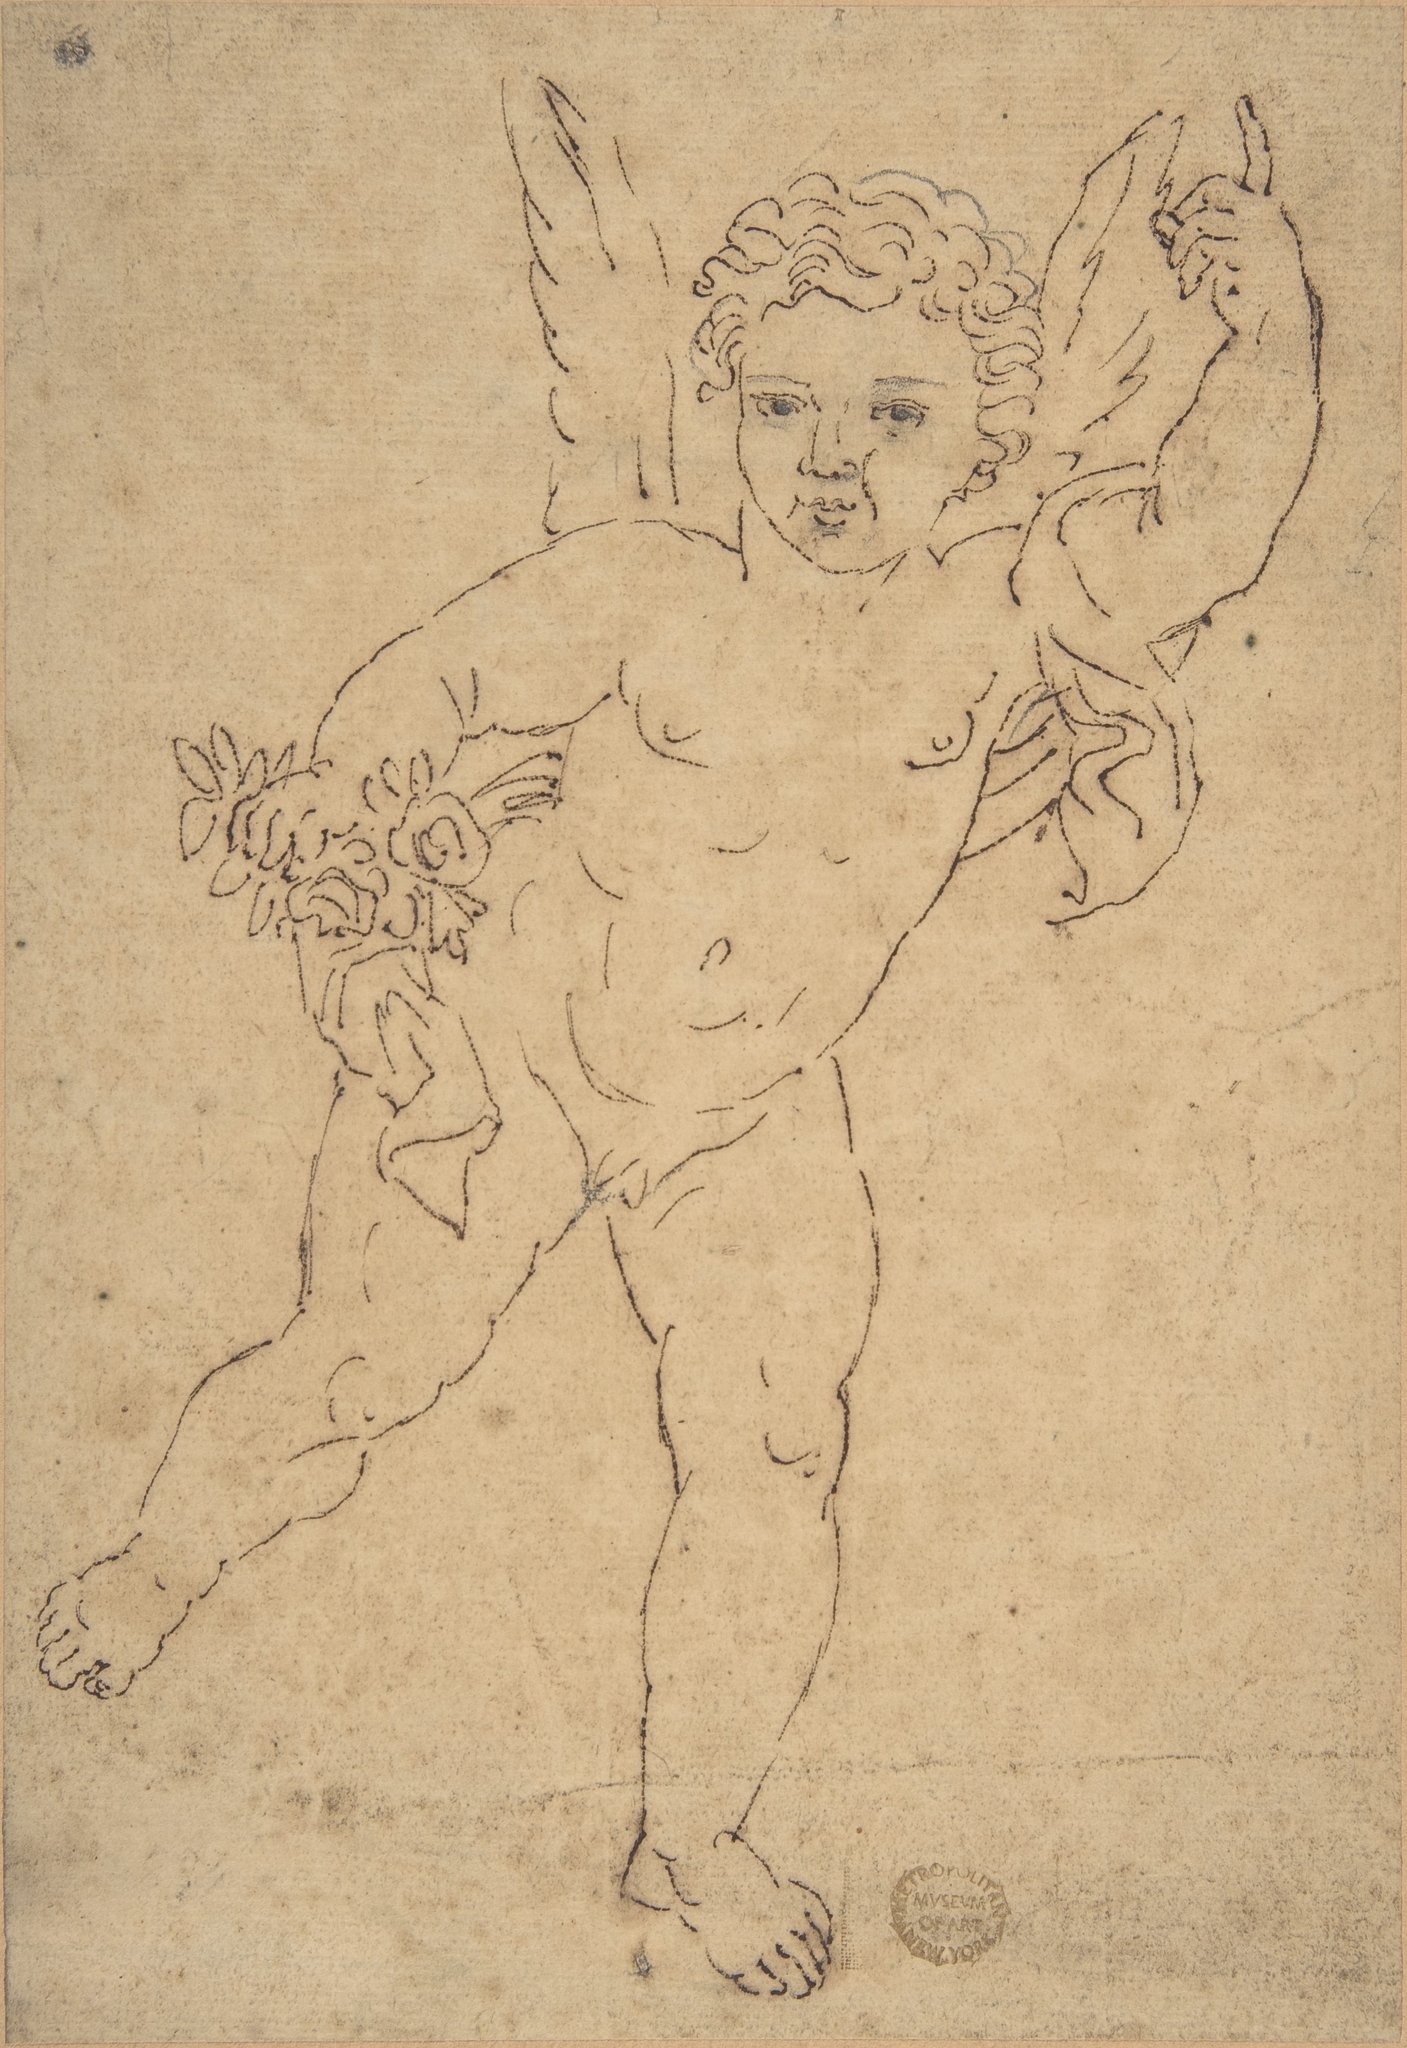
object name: drawing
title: Cupid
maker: anonymous, italian, 19th century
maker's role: artist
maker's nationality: italian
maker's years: 1800-1900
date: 1801-1900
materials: graphite, ink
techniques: pen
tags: cupid